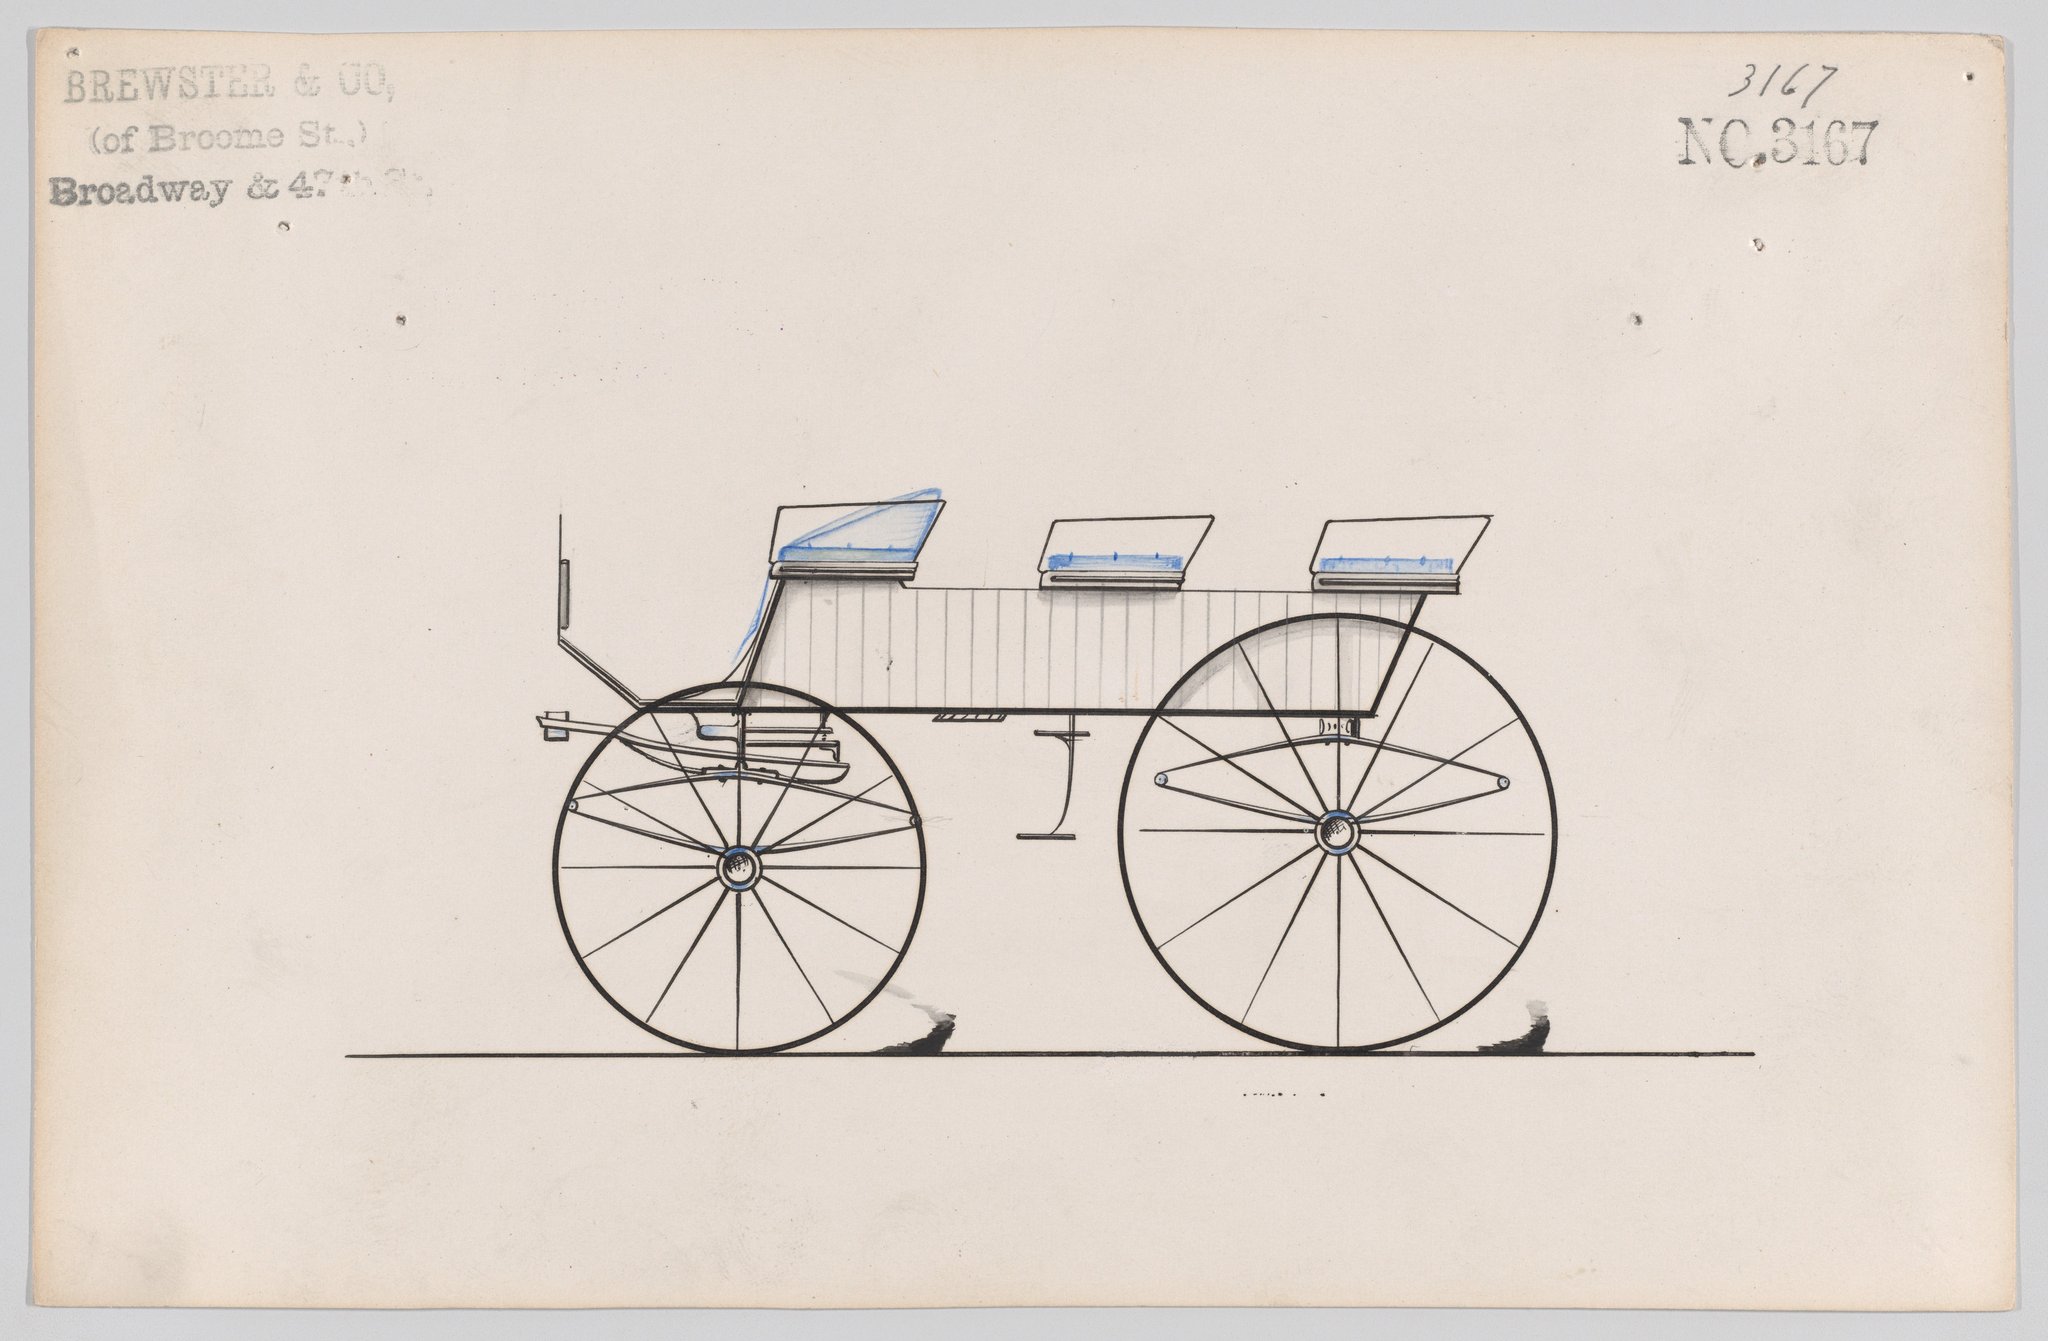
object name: drawing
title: Wagon #3167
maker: brewster & co.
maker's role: manufacturer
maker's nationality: american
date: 1875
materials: ink, watercolor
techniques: pen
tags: carriages